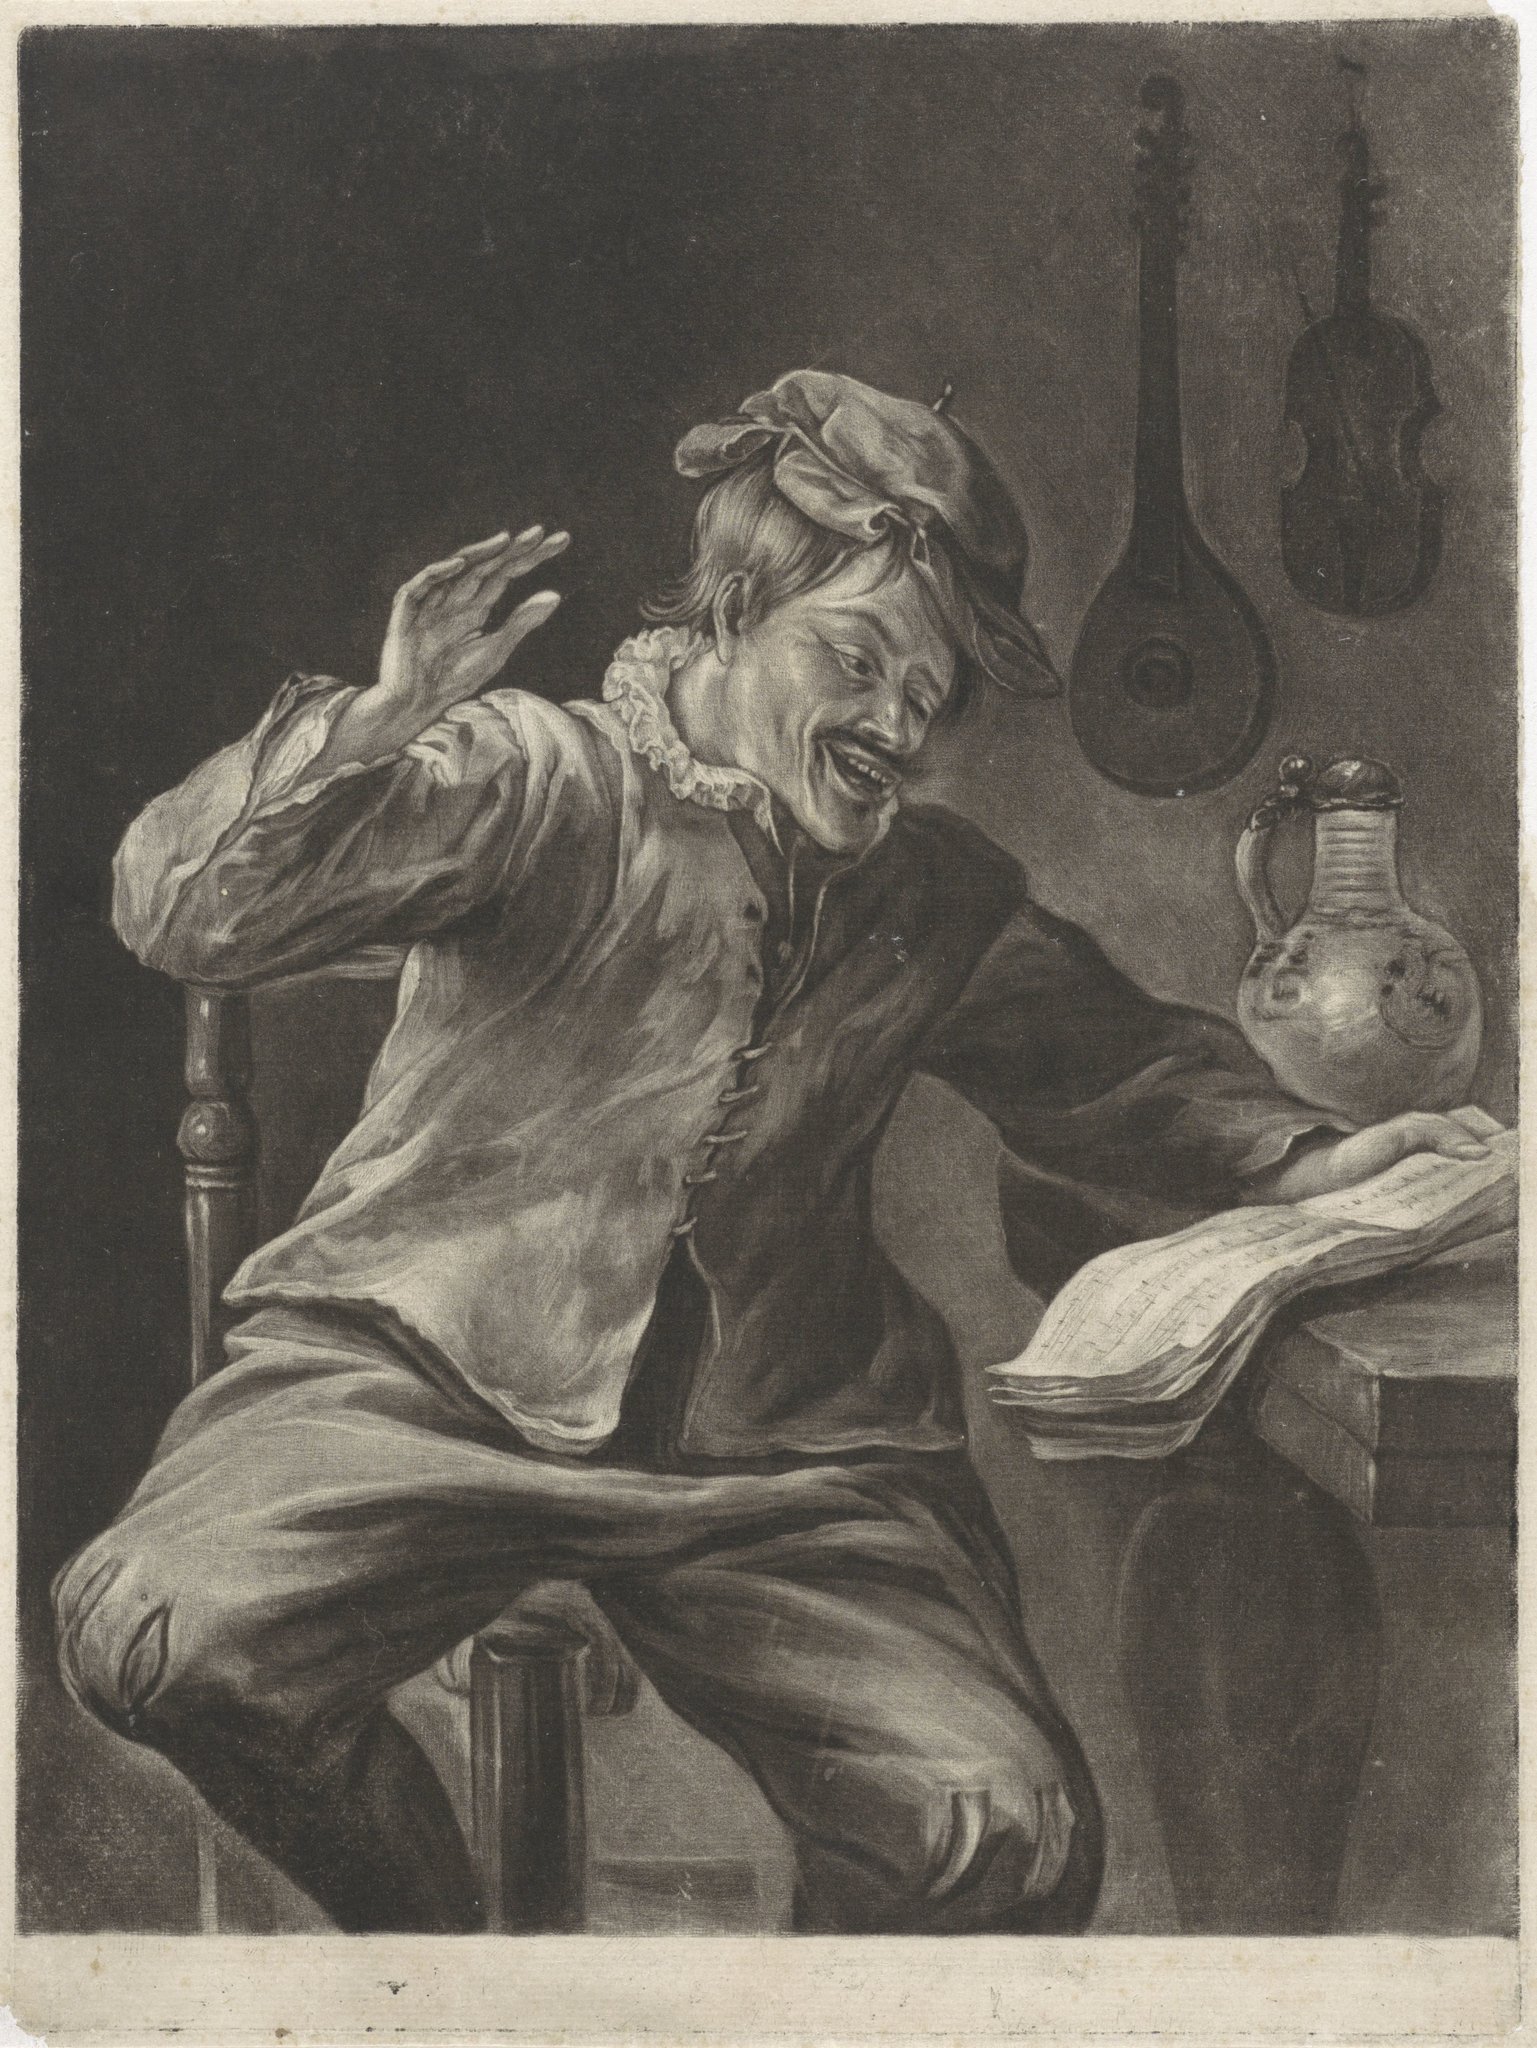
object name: print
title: Het Gehoor: zingende man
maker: jacob gole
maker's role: print maker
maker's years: 1660-1724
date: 1670-1724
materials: paper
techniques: mezzotint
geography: amsterdam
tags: hearing, listening (one of the five senses), violin, fiddle, vocal music, singing, lute, and special forms of lute, e.g.: theorbo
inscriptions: collector's mark: Lugt 2228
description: Het Gehoor. Een zingende man met bladmuziek. Aan de muur hangen een luit en een viool. De prent maakt deel uit van een serie met de vijf zintuigen.